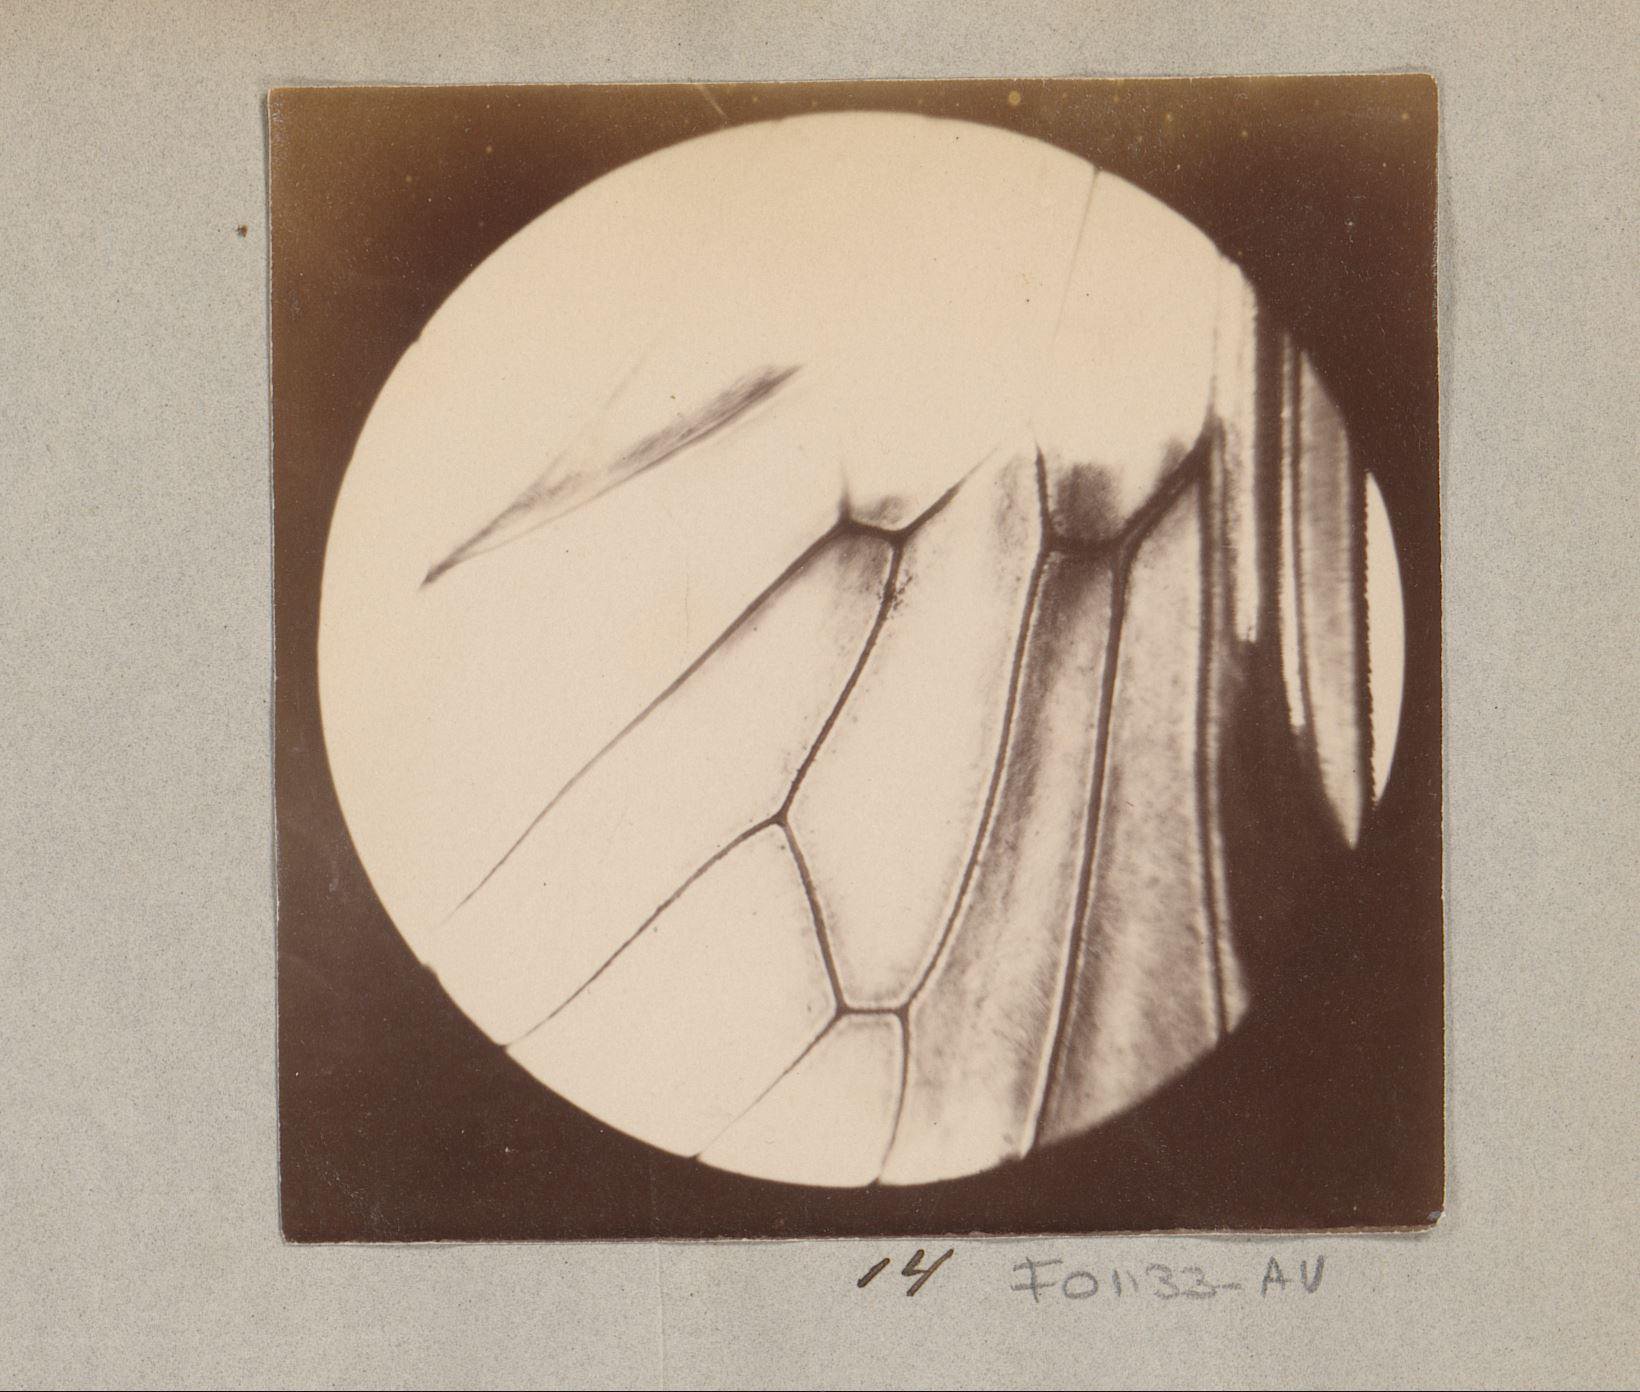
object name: album leaf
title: Microscopische opname van vleugel van een vlieg, dertig keer vergroot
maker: marinus pieter filbri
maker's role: instrument maker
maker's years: 1852-1917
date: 1887-1888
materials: paper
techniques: albumen print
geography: netherlands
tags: insects: fly, netherlands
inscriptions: inscription: ‘Nr. 14. Benaming Vleugel van een vlieg, 30 x vergroot, pose 5 min., bemerking Lomberg eig. prep.’, number: ‘14’